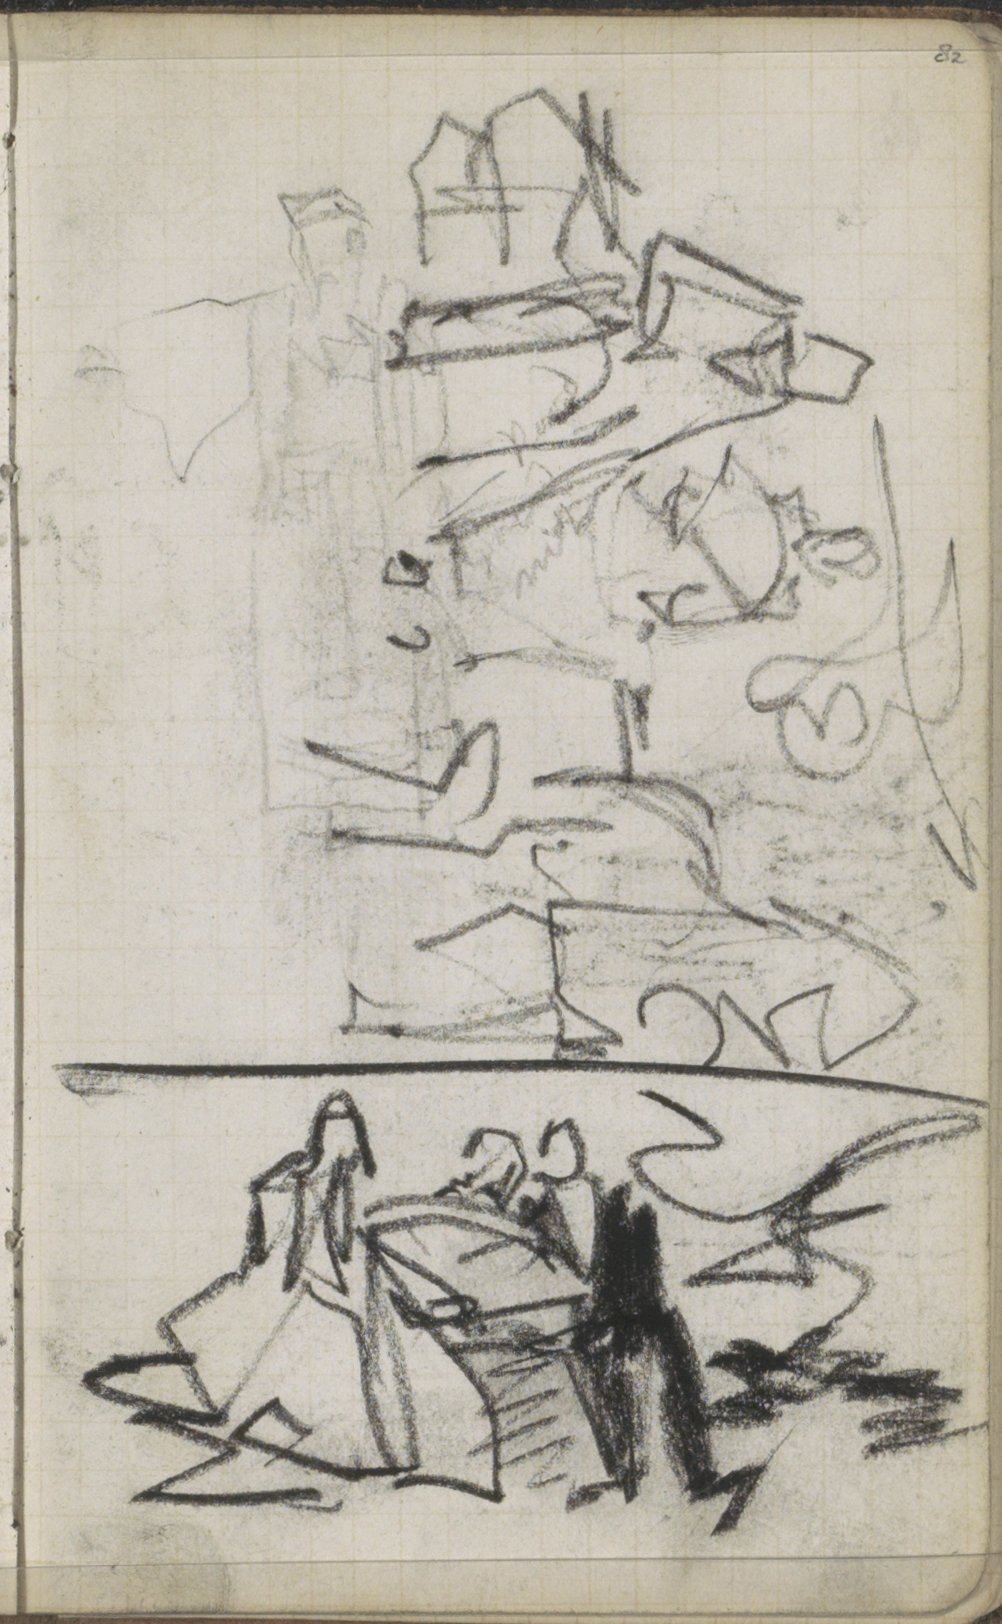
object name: sketchbook leaf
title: Studieblad, onder andere met een paar aan een tafel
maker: marius bauer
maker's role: draughtsman, print maker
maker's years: 1867-1932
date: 1879-1885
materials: chalk, charcoal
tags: sitting figure, adult woman, adult man, table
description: Pagina 82 uit een schetsboek met 58 bladen.